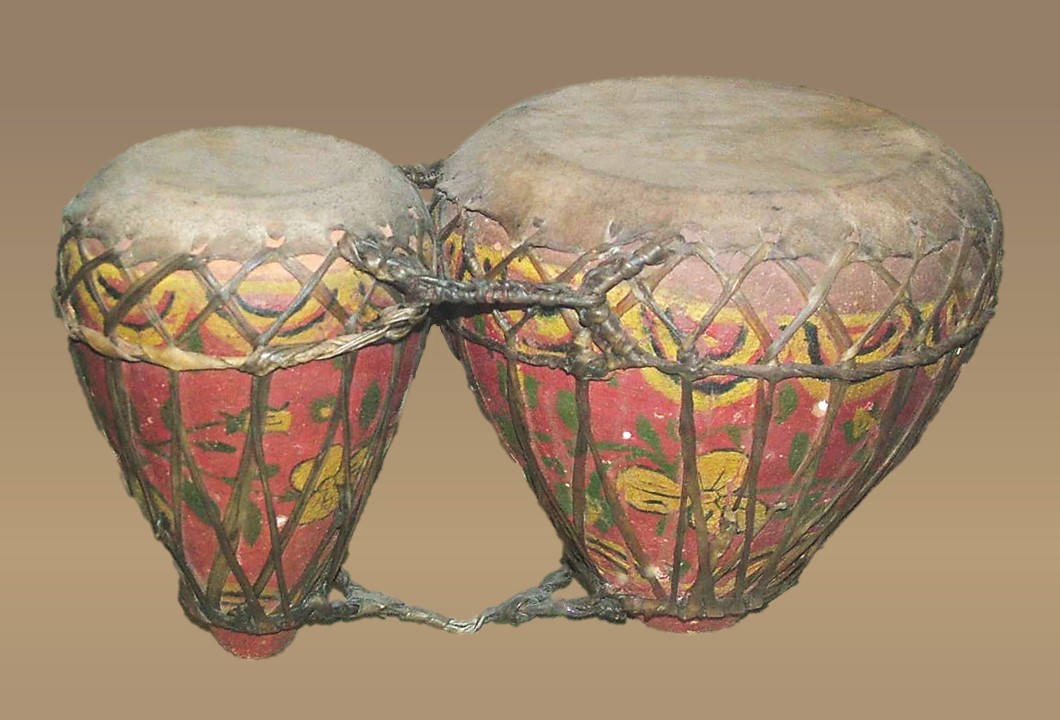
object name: diplipito dimplipito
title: Diplipito (dimplipito)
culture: caucasian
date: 1867-1900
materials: clay, cord, wood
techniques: polychrome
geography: georgia